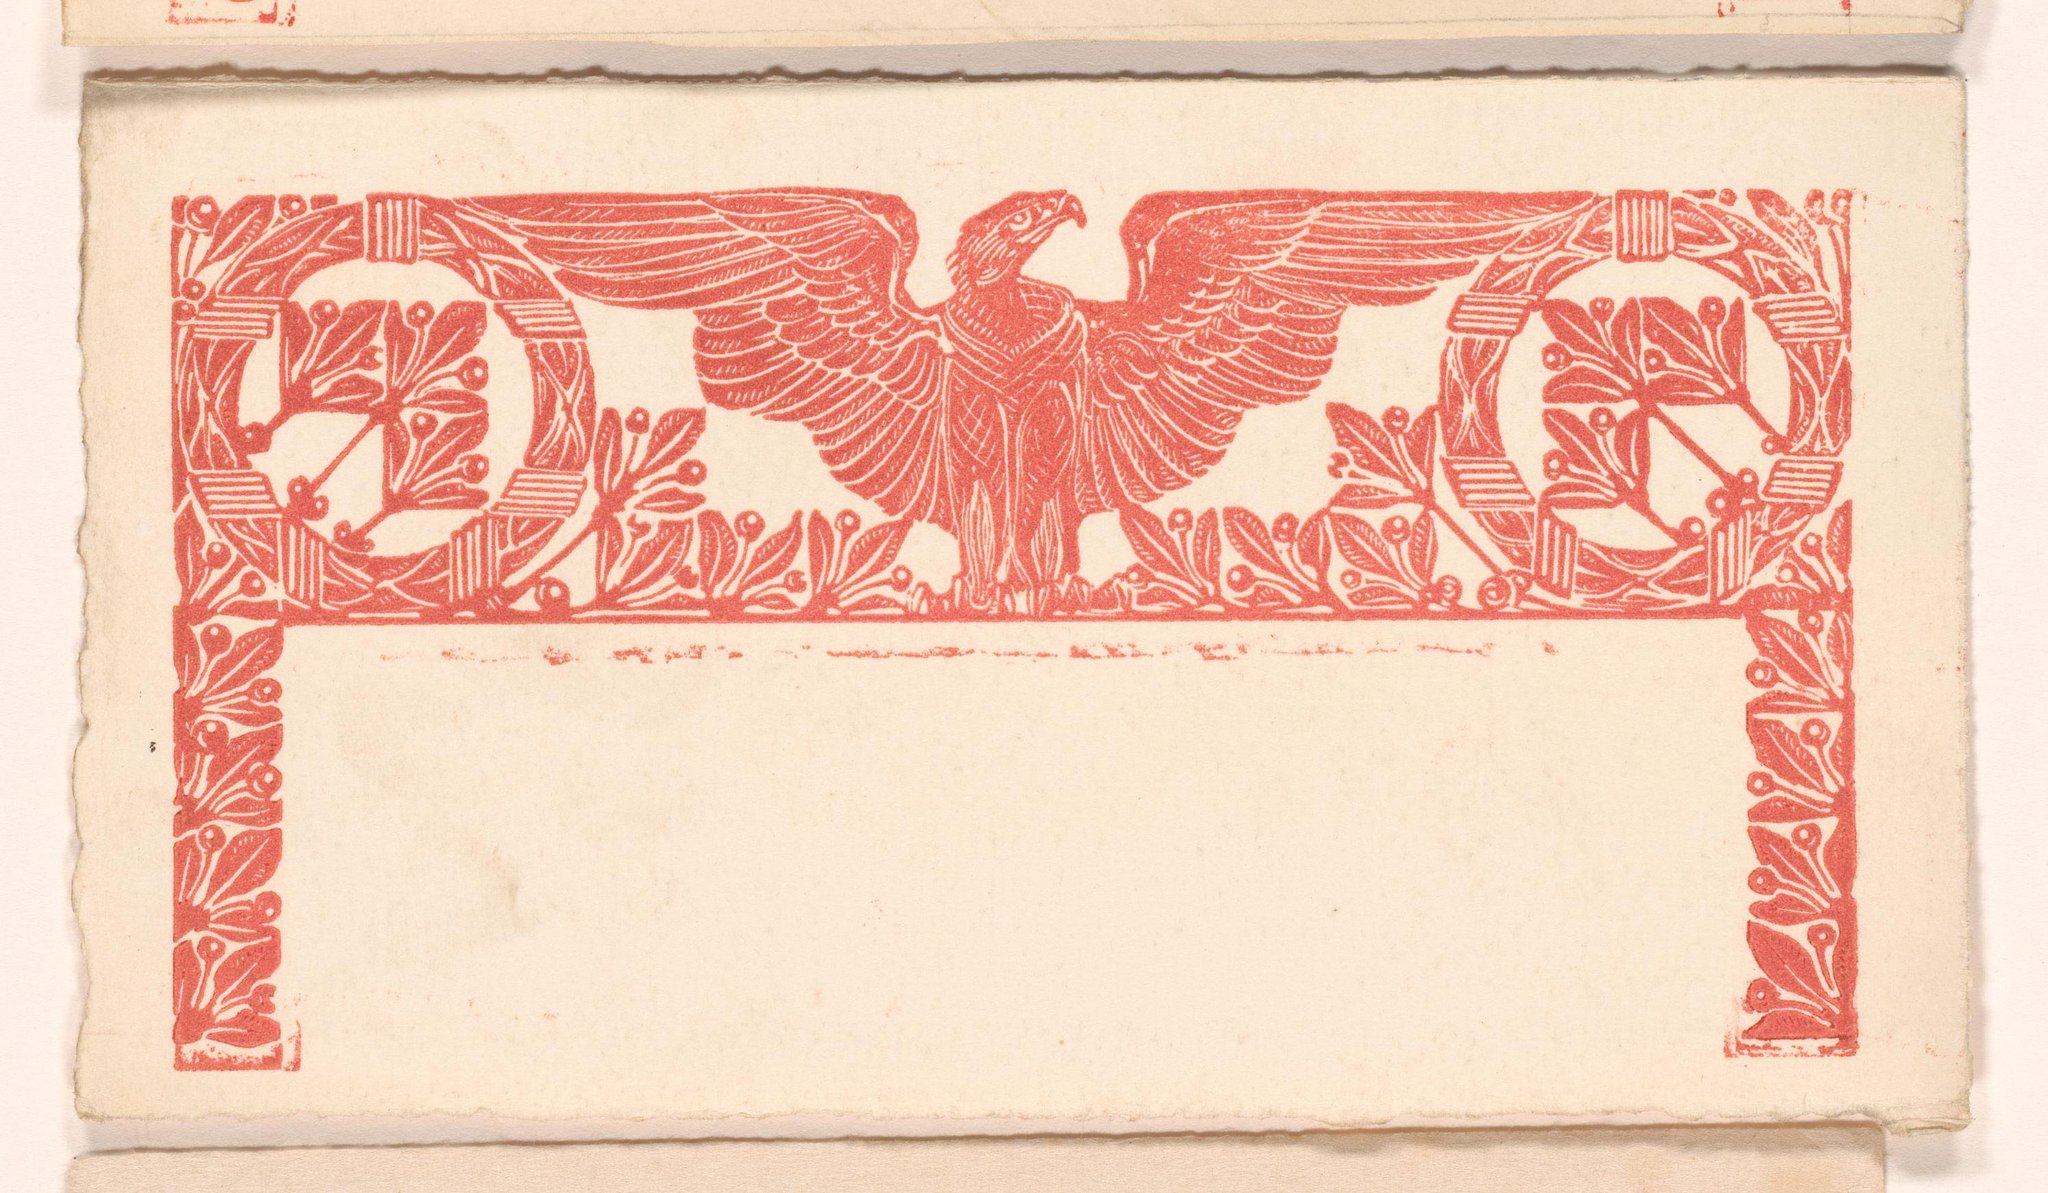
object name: print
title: Ornamentele rand met bladeren en adelaar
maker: bernard willem wierink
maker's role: draughtsman, print maker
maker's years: 1856-1939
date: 1910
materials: paper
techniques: relief print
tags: predatory birds: eagle, fable of reynard the fox, foliage, tendrils, branches ~ ornament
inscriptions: collector's mark: Lugt 2228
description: Ontwerp voor: Streuvels, Stijn (Frank Lateur). Reinaert de Vos naar verschillende uitgaven van het middeleeuwsche epos. Amsterdam: L.J. Veen, 1910. Deze prent is vermoedelijk een plaatsnede, ook al wordt in de literatuur veelal gesproken over een houtsnede. Voor zover Wierink zijn prenten in hoogdruk zelf nader heeft omschreven, heeft hij altijd de term 'plaatsnede' gebruikt.